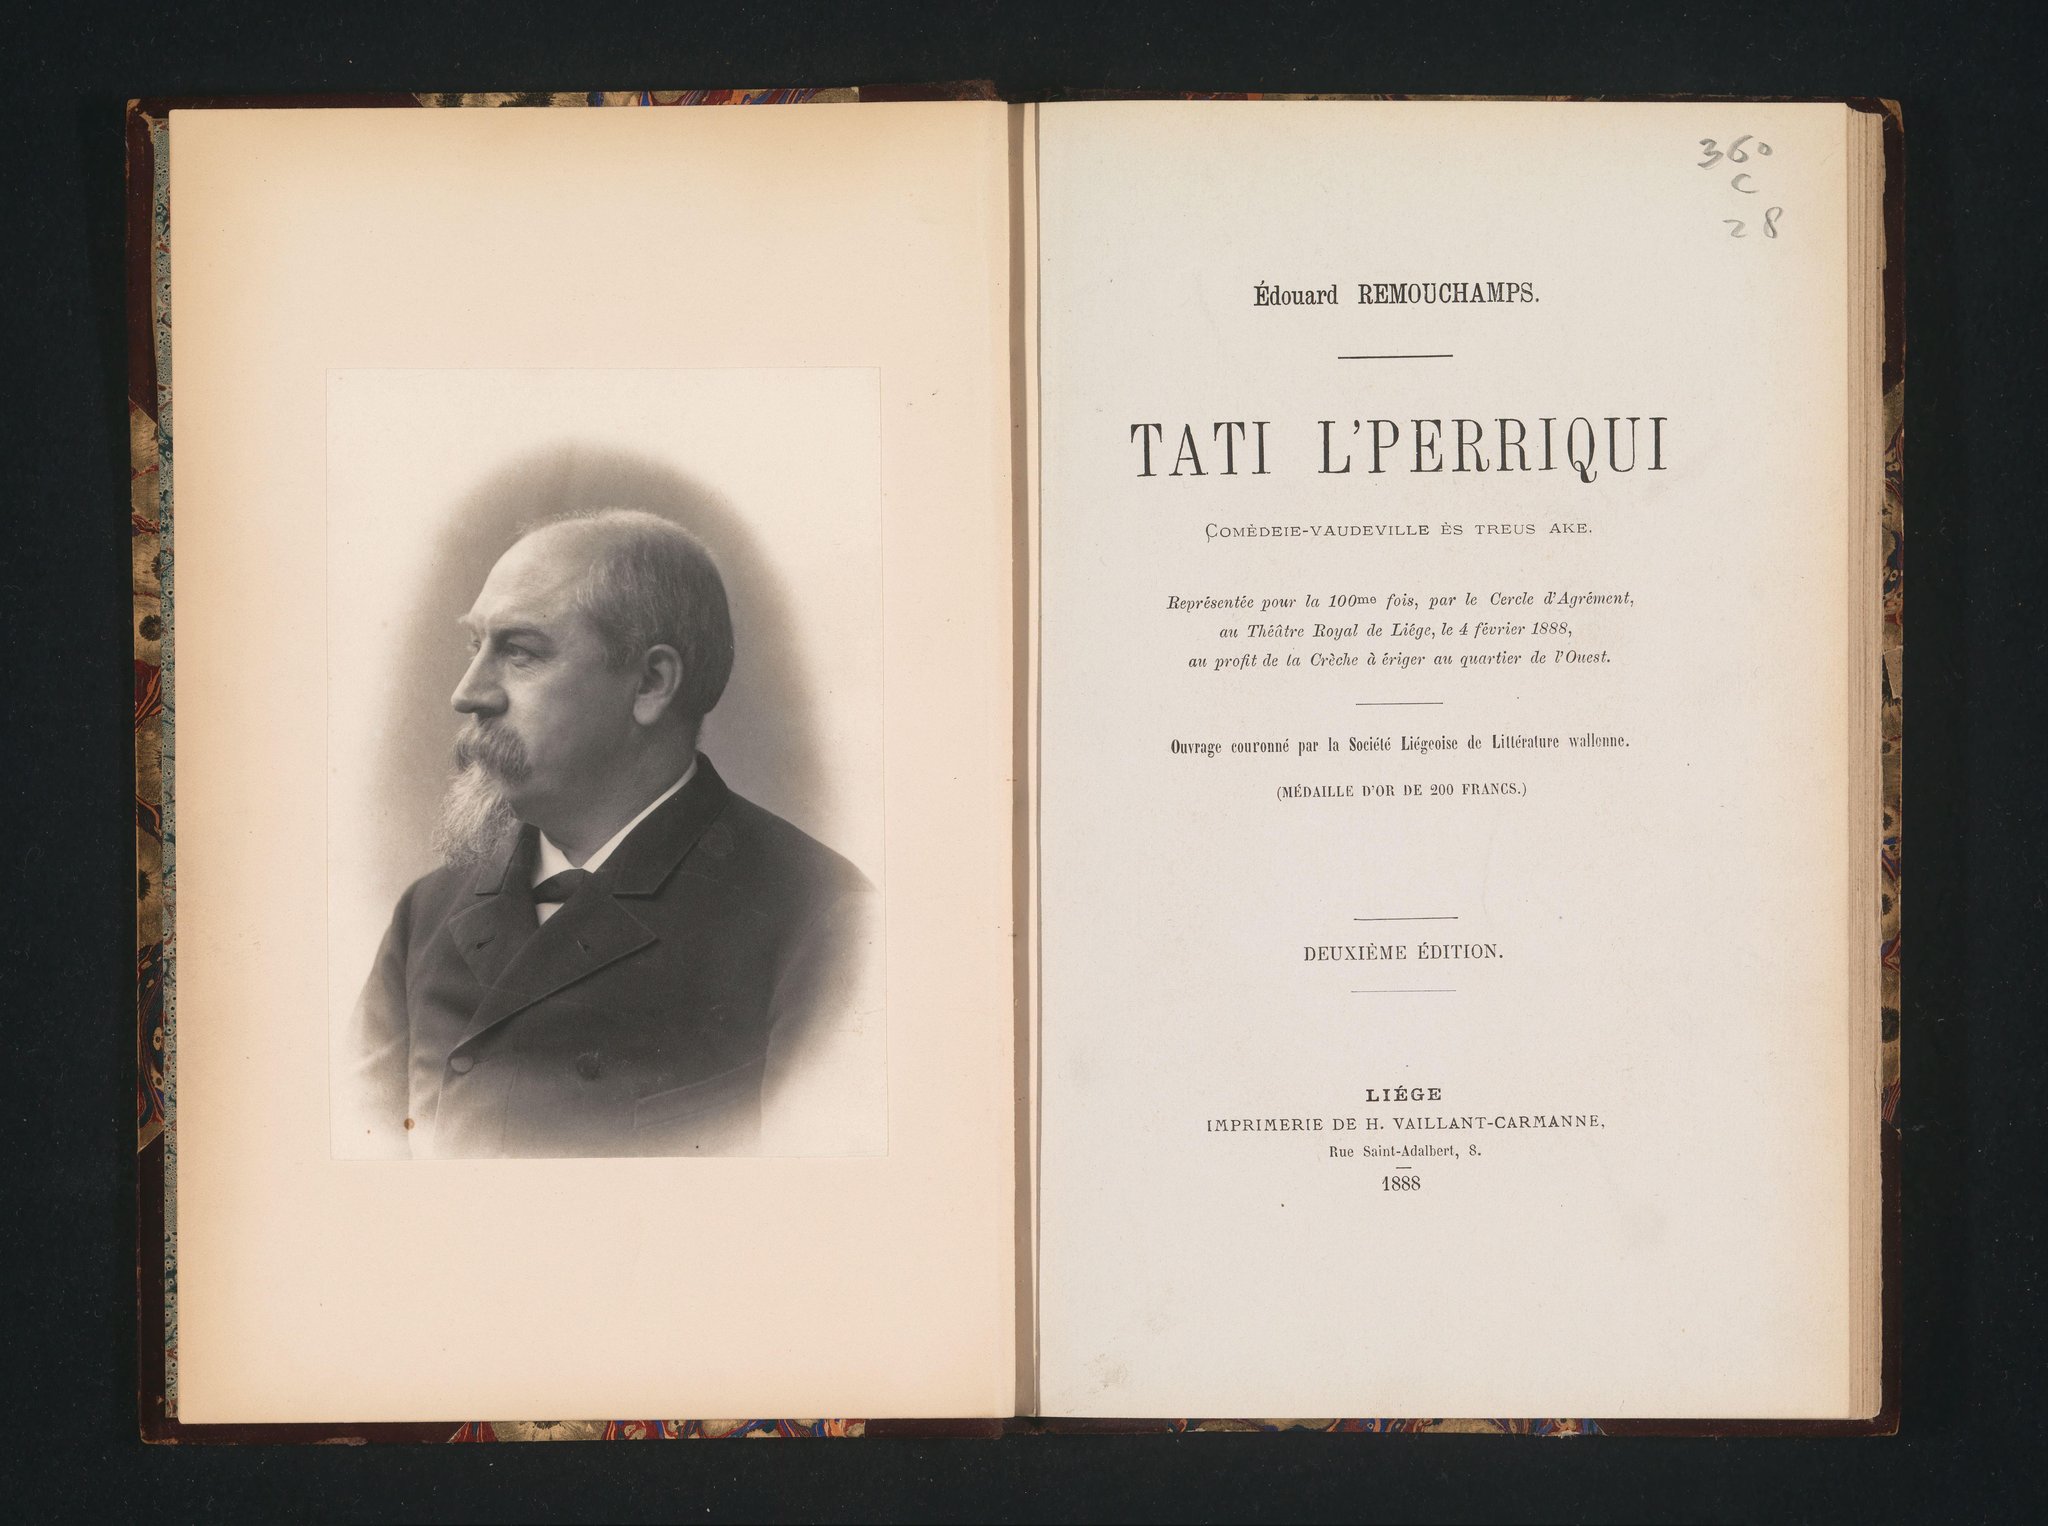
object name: book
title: Tati l'perriqui : comèdeie-vaudeville ès treus ake / Édouard Remouchamps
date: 1888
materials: cardboard, leather, linen, paper, photographic support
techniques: albumen print, platinum process, printing, marbled paper, marbling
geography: liège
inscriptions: dedication: ‘A mon cher collègue Monsieur E. Duchesne./ Hommage de l'auteur./ E. Remouchamps/ Liège le 16 Janvier 1889.’, annotation: ‘APR/ 1995’, number: ‘1800’